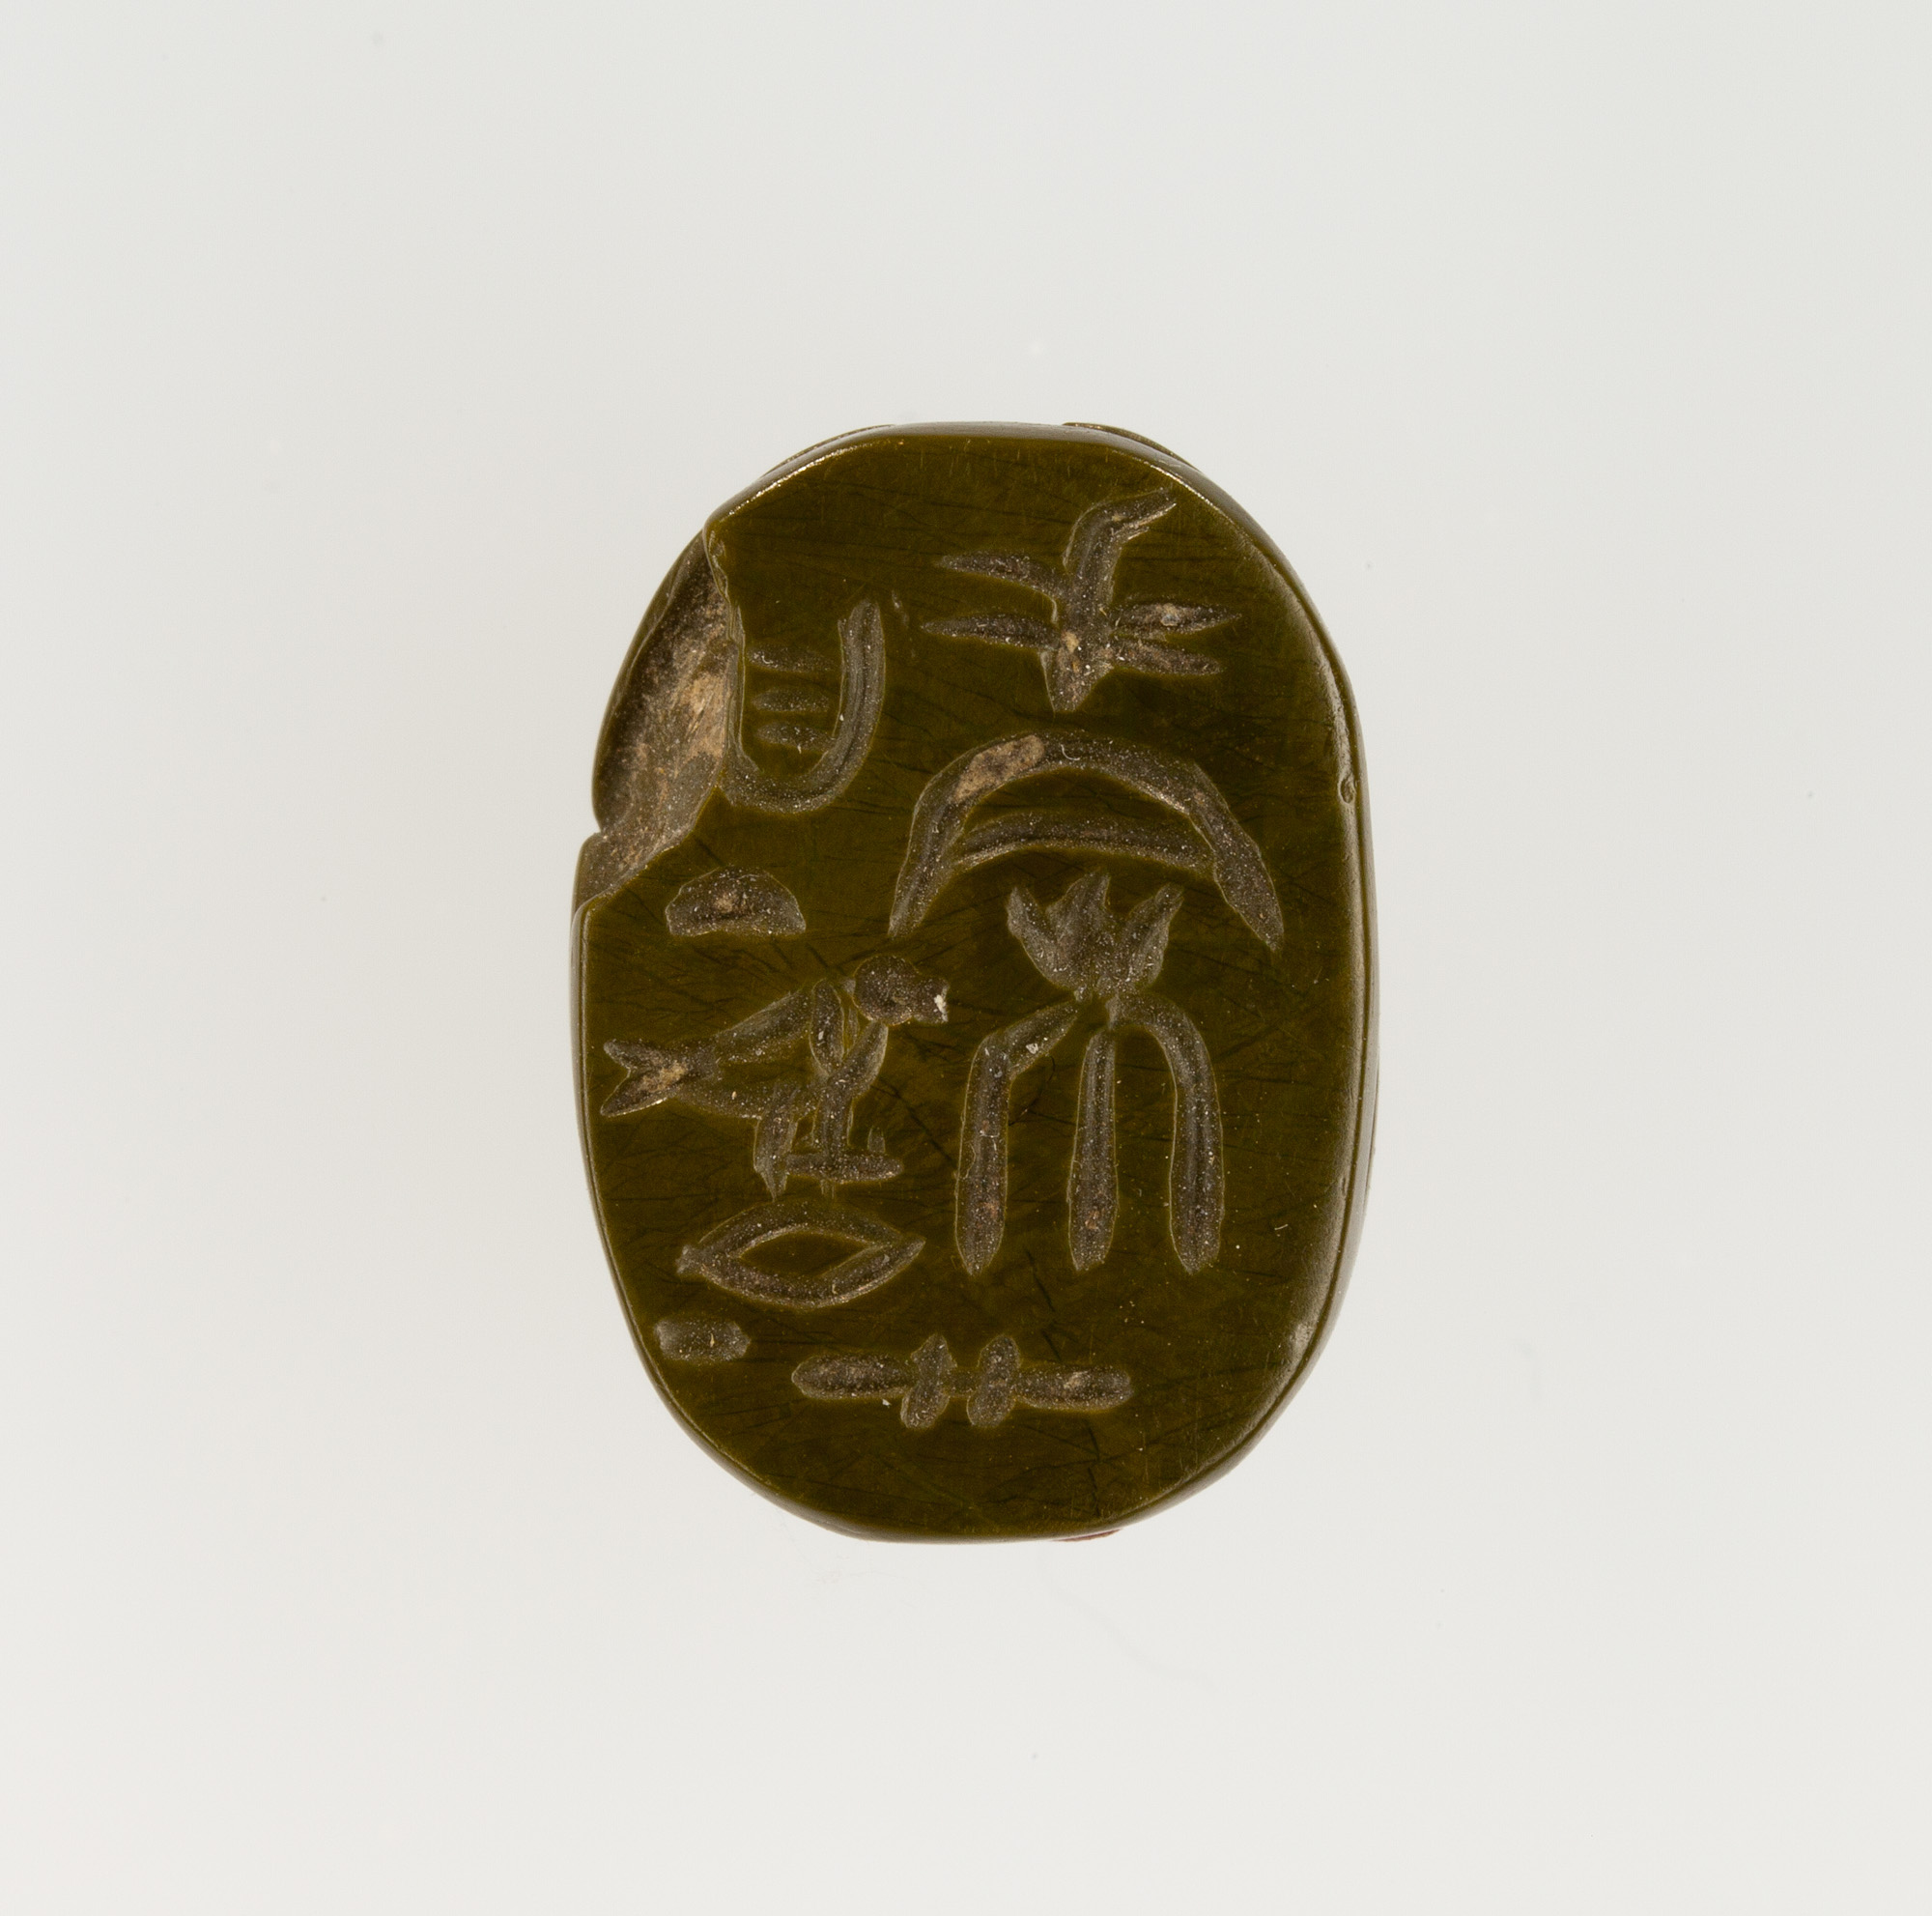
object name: scarab, ahmose nefertari, principal queen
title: Scarab Inscribed for the King's Principal Wife Ahmose(-Nefertari)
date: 1550-1525 BCE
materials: stone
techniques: glazing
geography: egypt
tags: hieroglyphs,scarabs